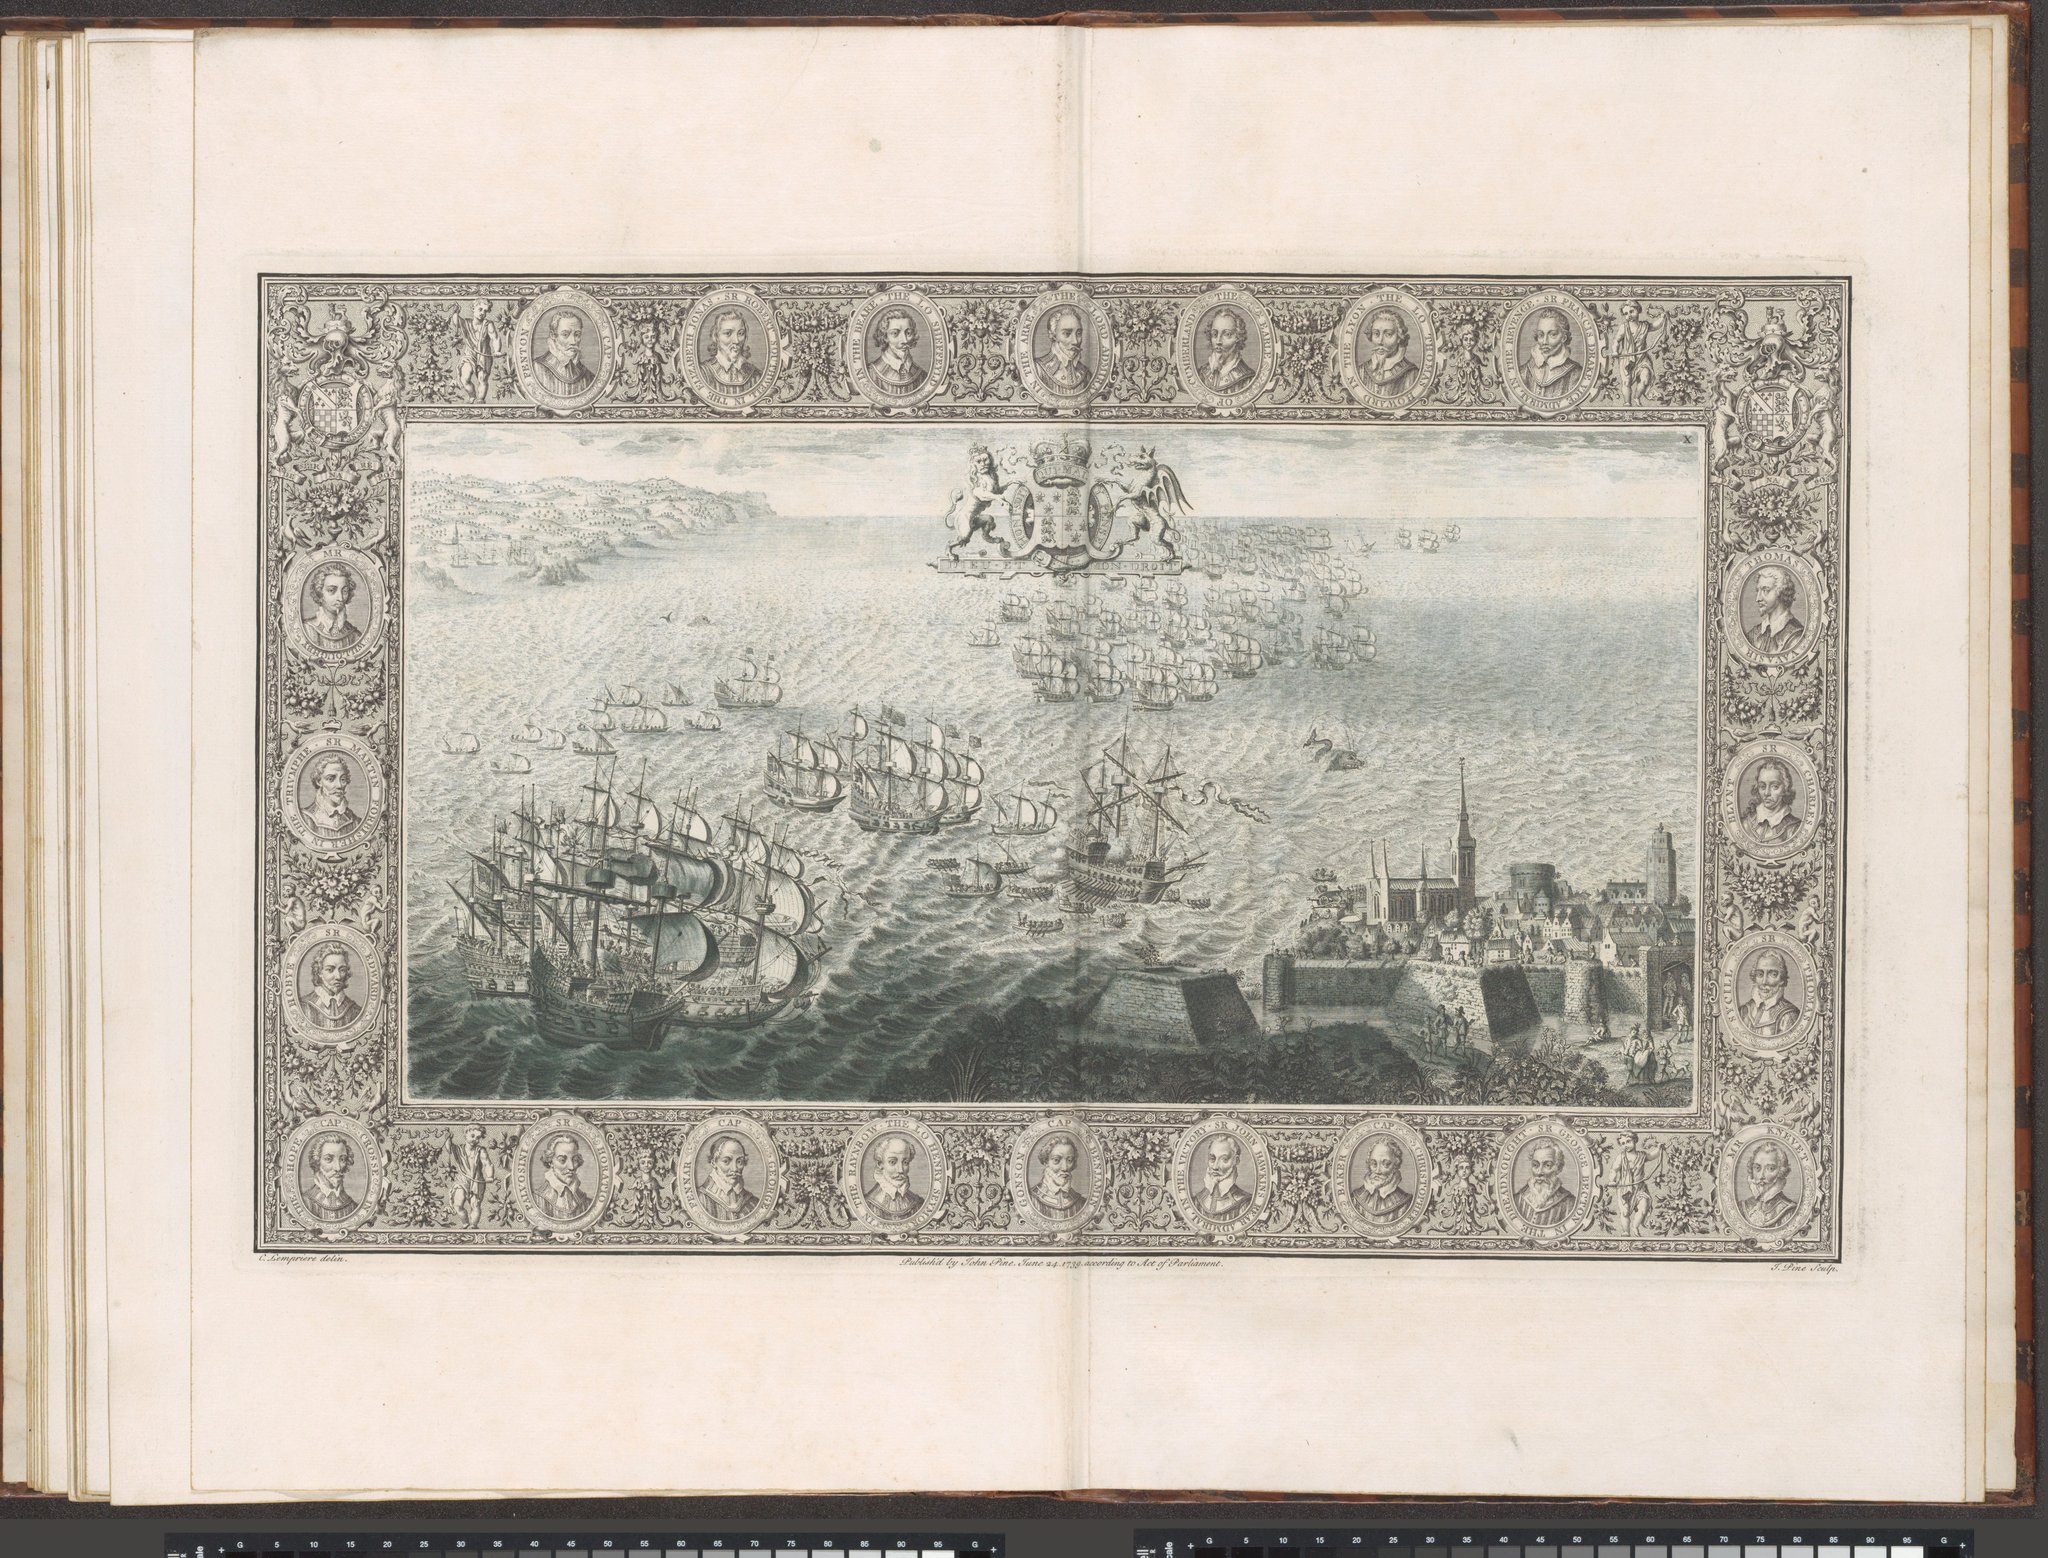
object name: album leaf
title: Reproductie van een wandtapijt over de Spaanse Armada (29-31 juli)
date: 1739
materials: paper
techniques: engraving, etching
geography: london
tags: plymouth, politician, coat of arms (as symbol of the state, etc.), monkeys, apes, birds, battle (+ naval force), tapestry, armorial bearing, heraldry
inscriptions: date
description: Reproductie van een wandtapijt gemaakt in opdracht van Charles Howard (1536-14 december 1624), Lord High Admiral. Het tapijt werd geweven door Francis Aertsz Spierincx in Delft, naar het karton van Hendrik Cornelisz Vroom. Vroom gebruikte als leidraad voor zijn ontwerp een getekende kaart van Robert Adams uit 1588 of de prent die daarvan twee jaar later werd gemaakt en uitgegeven door Augustine Ryther. Deze reproductie werd volgens de tekst van de prent gegraveerd door John Pine naar de tekening die Clement Lemprière van het tapijt maakte. Het tapijt zelf ging in 1834 bij een brand verloren.